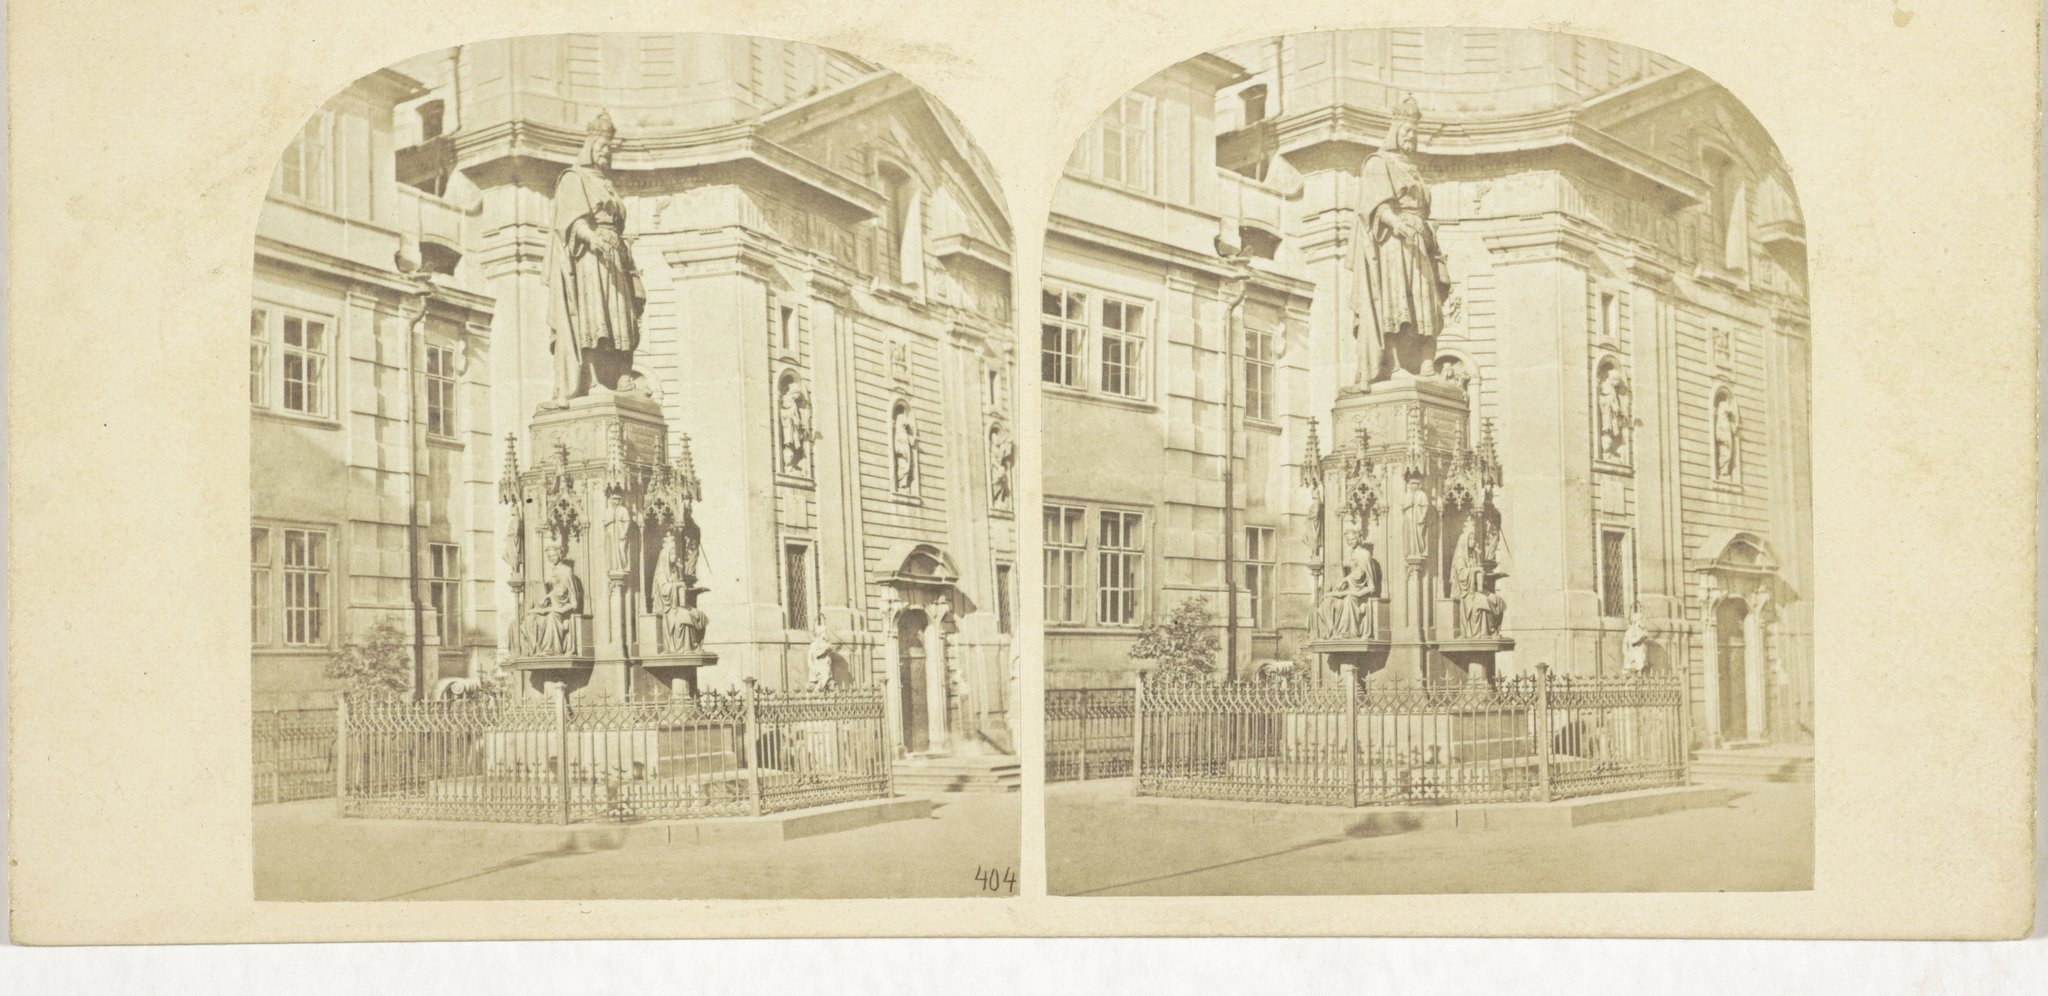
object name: stereograph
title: M.ent de l'Empereur Charles à Prague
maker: Anonymous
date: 1857-1863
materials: cardboard, paper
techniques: albumen print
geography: prague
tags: church (exterior), monument, statue, prague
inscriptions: inscription: ‘404’, number: ‘404’